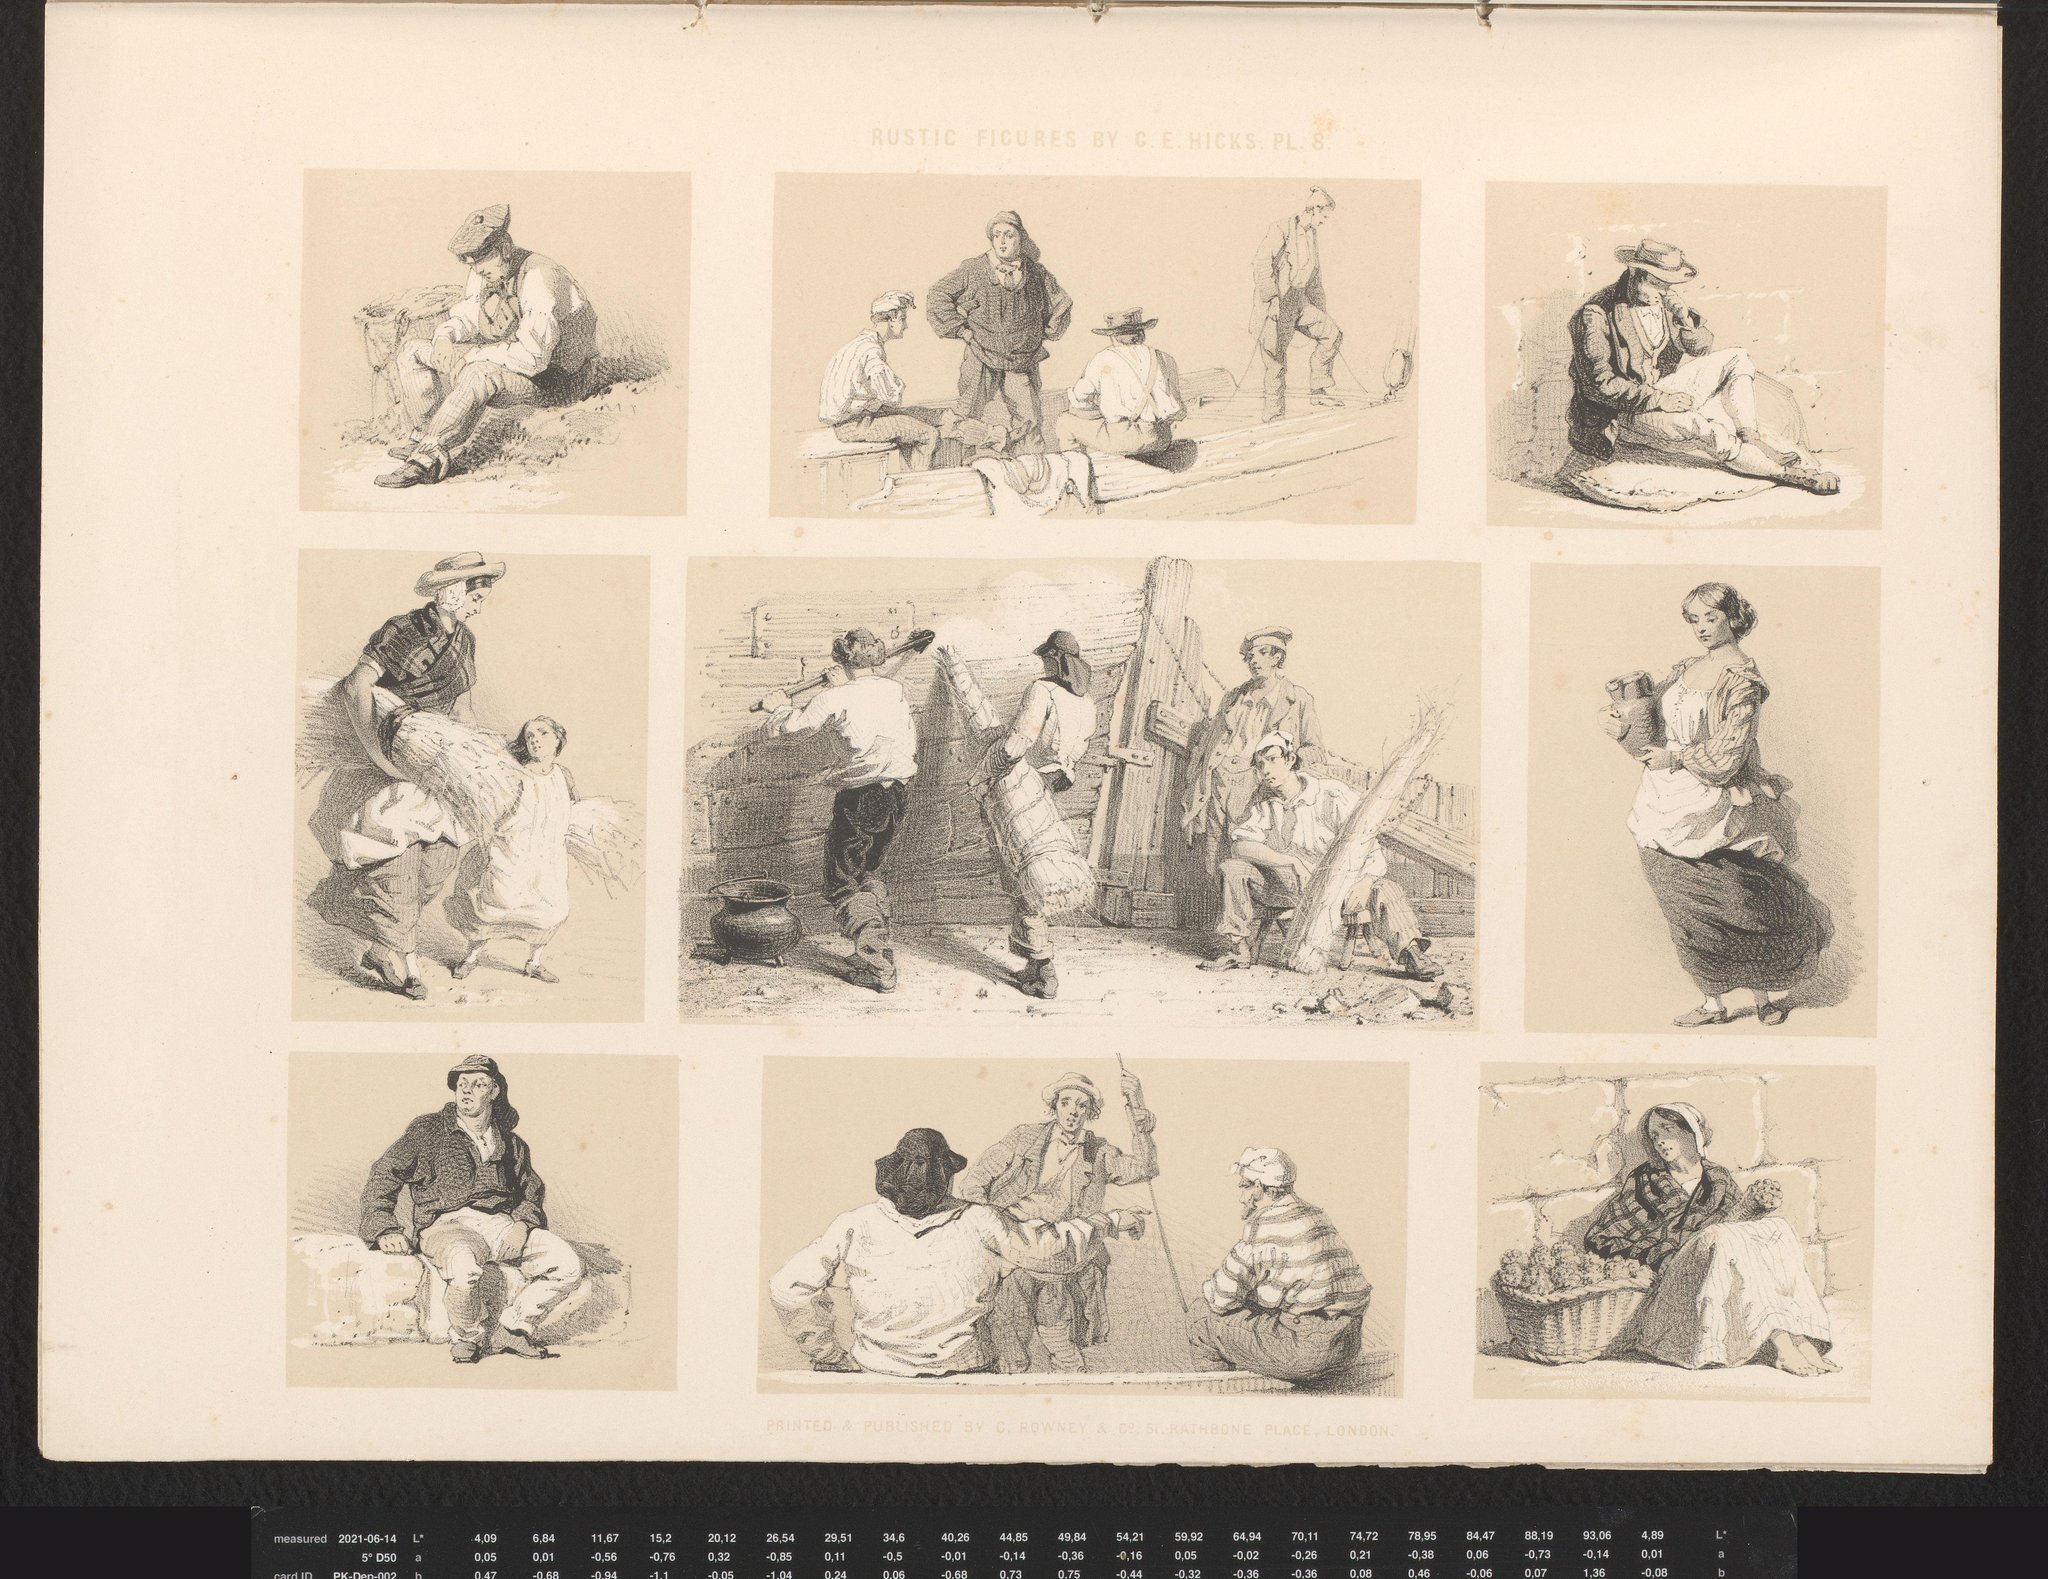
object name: print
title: Rustic figures by G.E. Hicks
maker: george elgar hicks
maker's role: print maker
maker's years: 1824-1914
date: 1850-1855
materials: paper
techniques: tone lithography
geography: london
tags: fence, wall, paling, farmers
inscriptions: collector's mark: Lugt 2228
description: Deze prent behoort tot de serie 'Rustic figures by G.E. Hicks'. Deze serie is uitgegeven in tenminste drie delen met elk zes lithografieën.